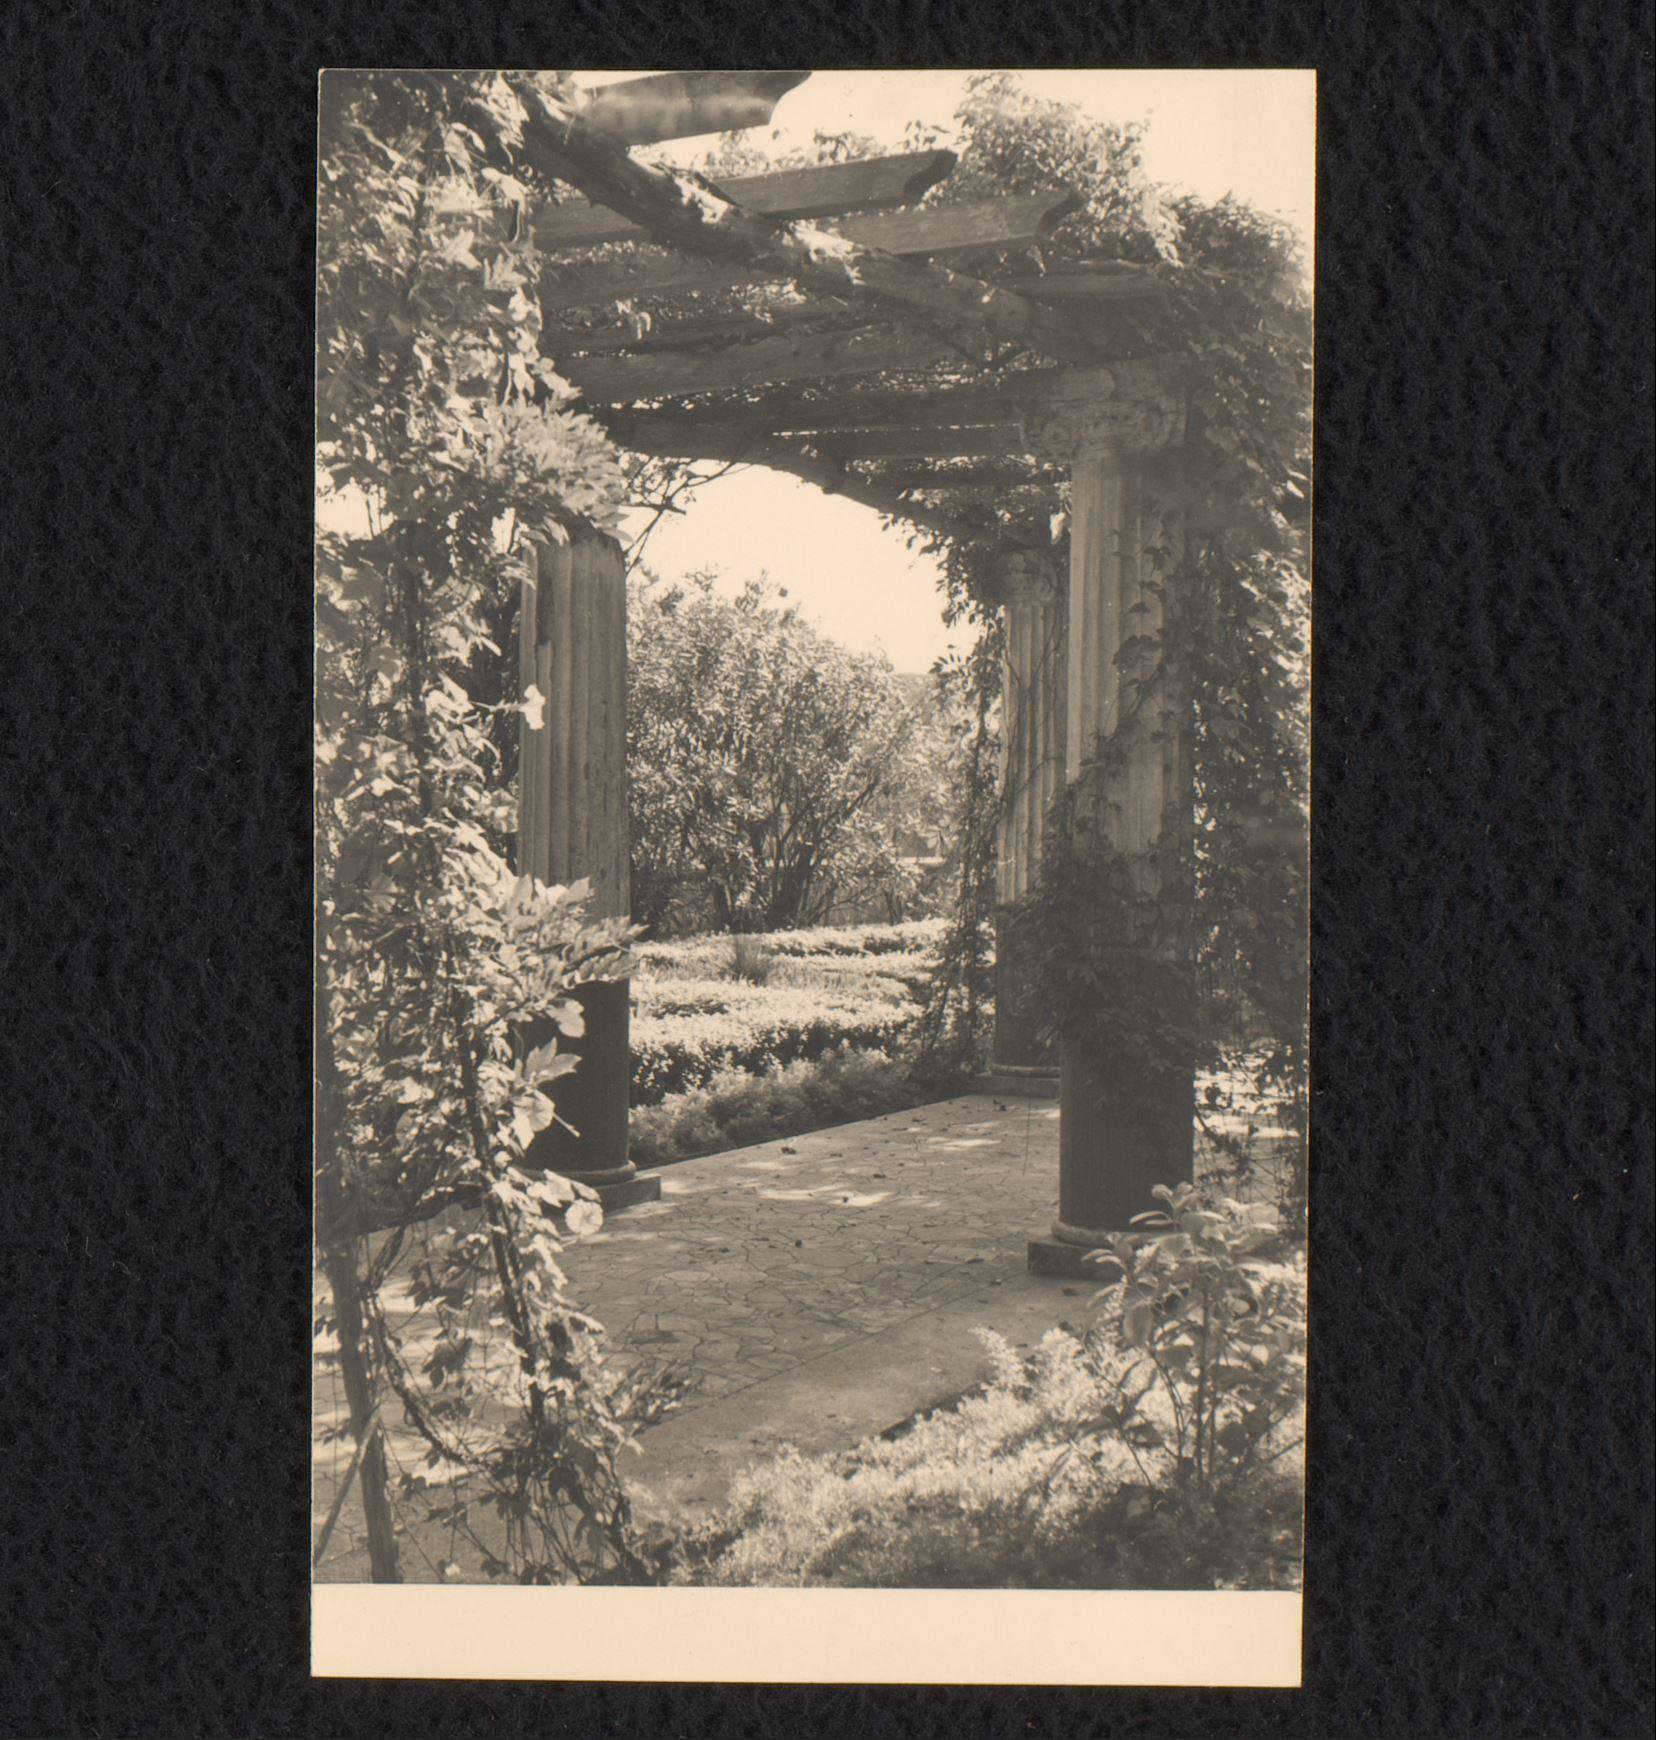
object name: ansichtkaart, prentbriefkaart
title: Pergola in de tuin van Villa Tritone, Sorrento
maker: Anonymous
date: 1930-1950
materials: paper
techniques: gelatin silver print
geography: sorrento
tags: garden, pergola